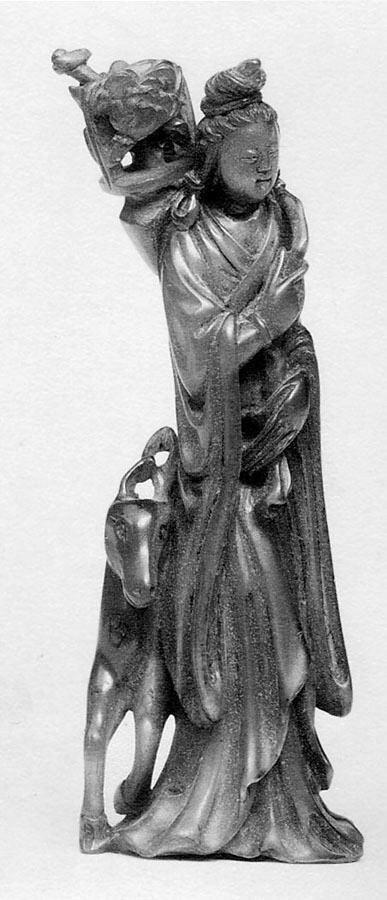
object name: figure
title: Woman Carrying Basket of Flowers (?) with Deer Beside Her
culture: chinese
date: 1801-1900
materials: horn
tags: women,deer